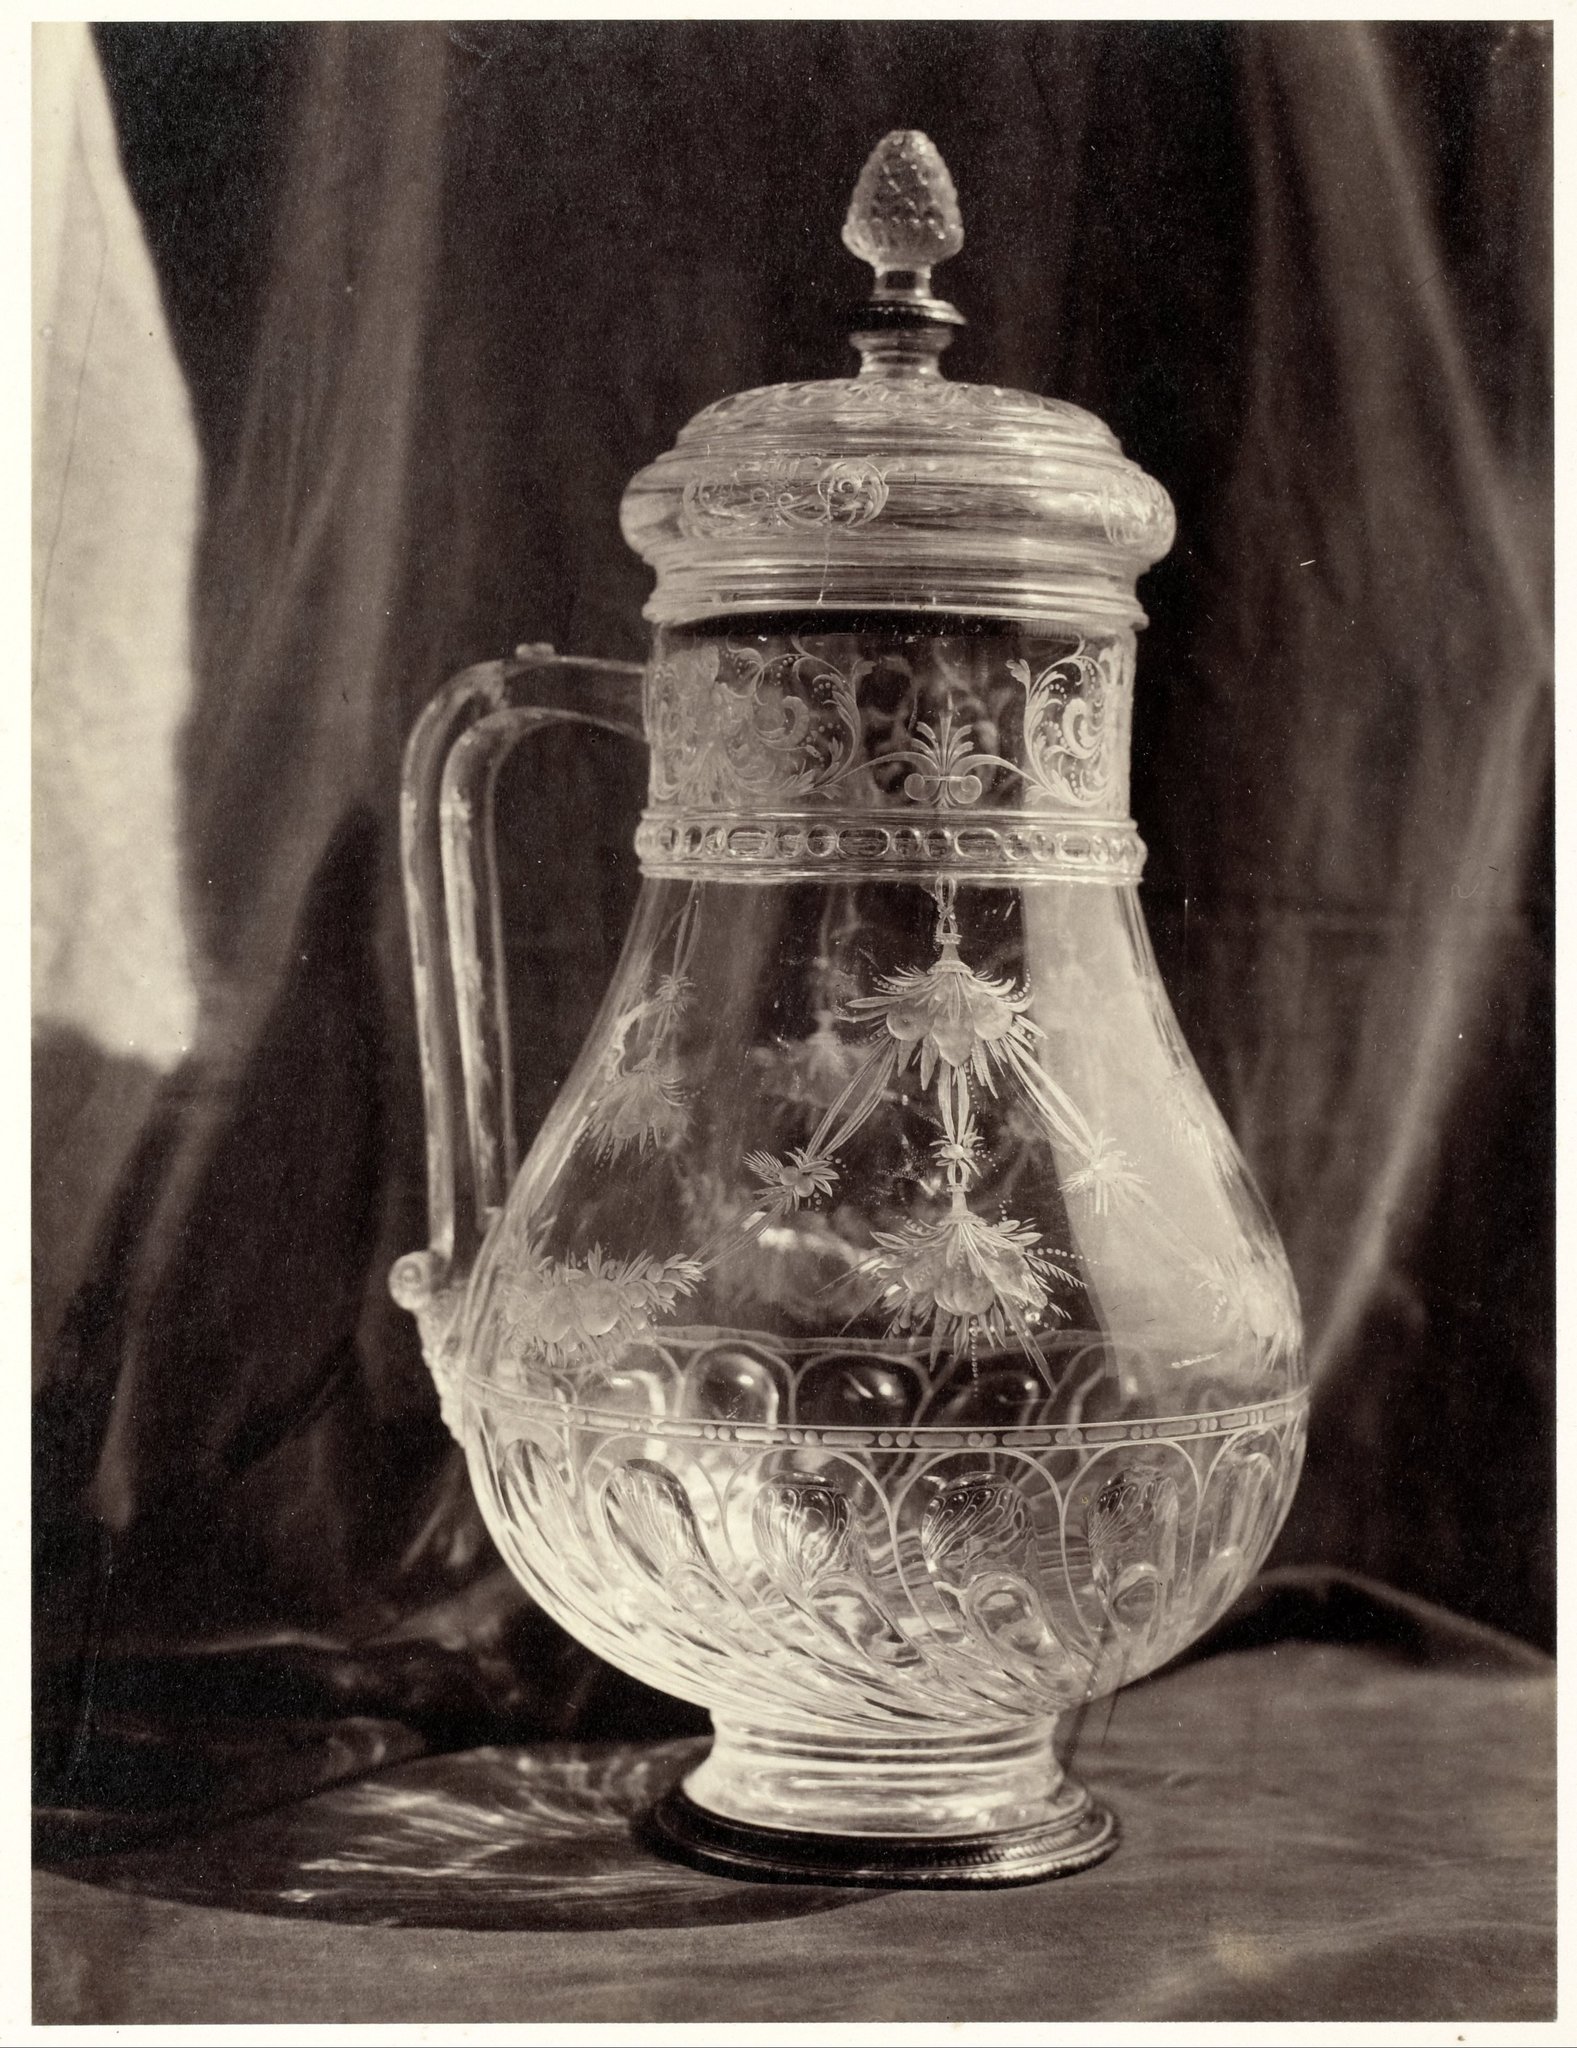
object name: photomechanical print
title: Kristallen gegraveerde kan, uit het Louvre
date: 1866-1890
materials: paper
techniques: woodburytype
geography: louvre museum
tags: container of glass: bottle, jar, vase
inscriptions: inscription: ‘Photographed by C. Thurston Thompson.’